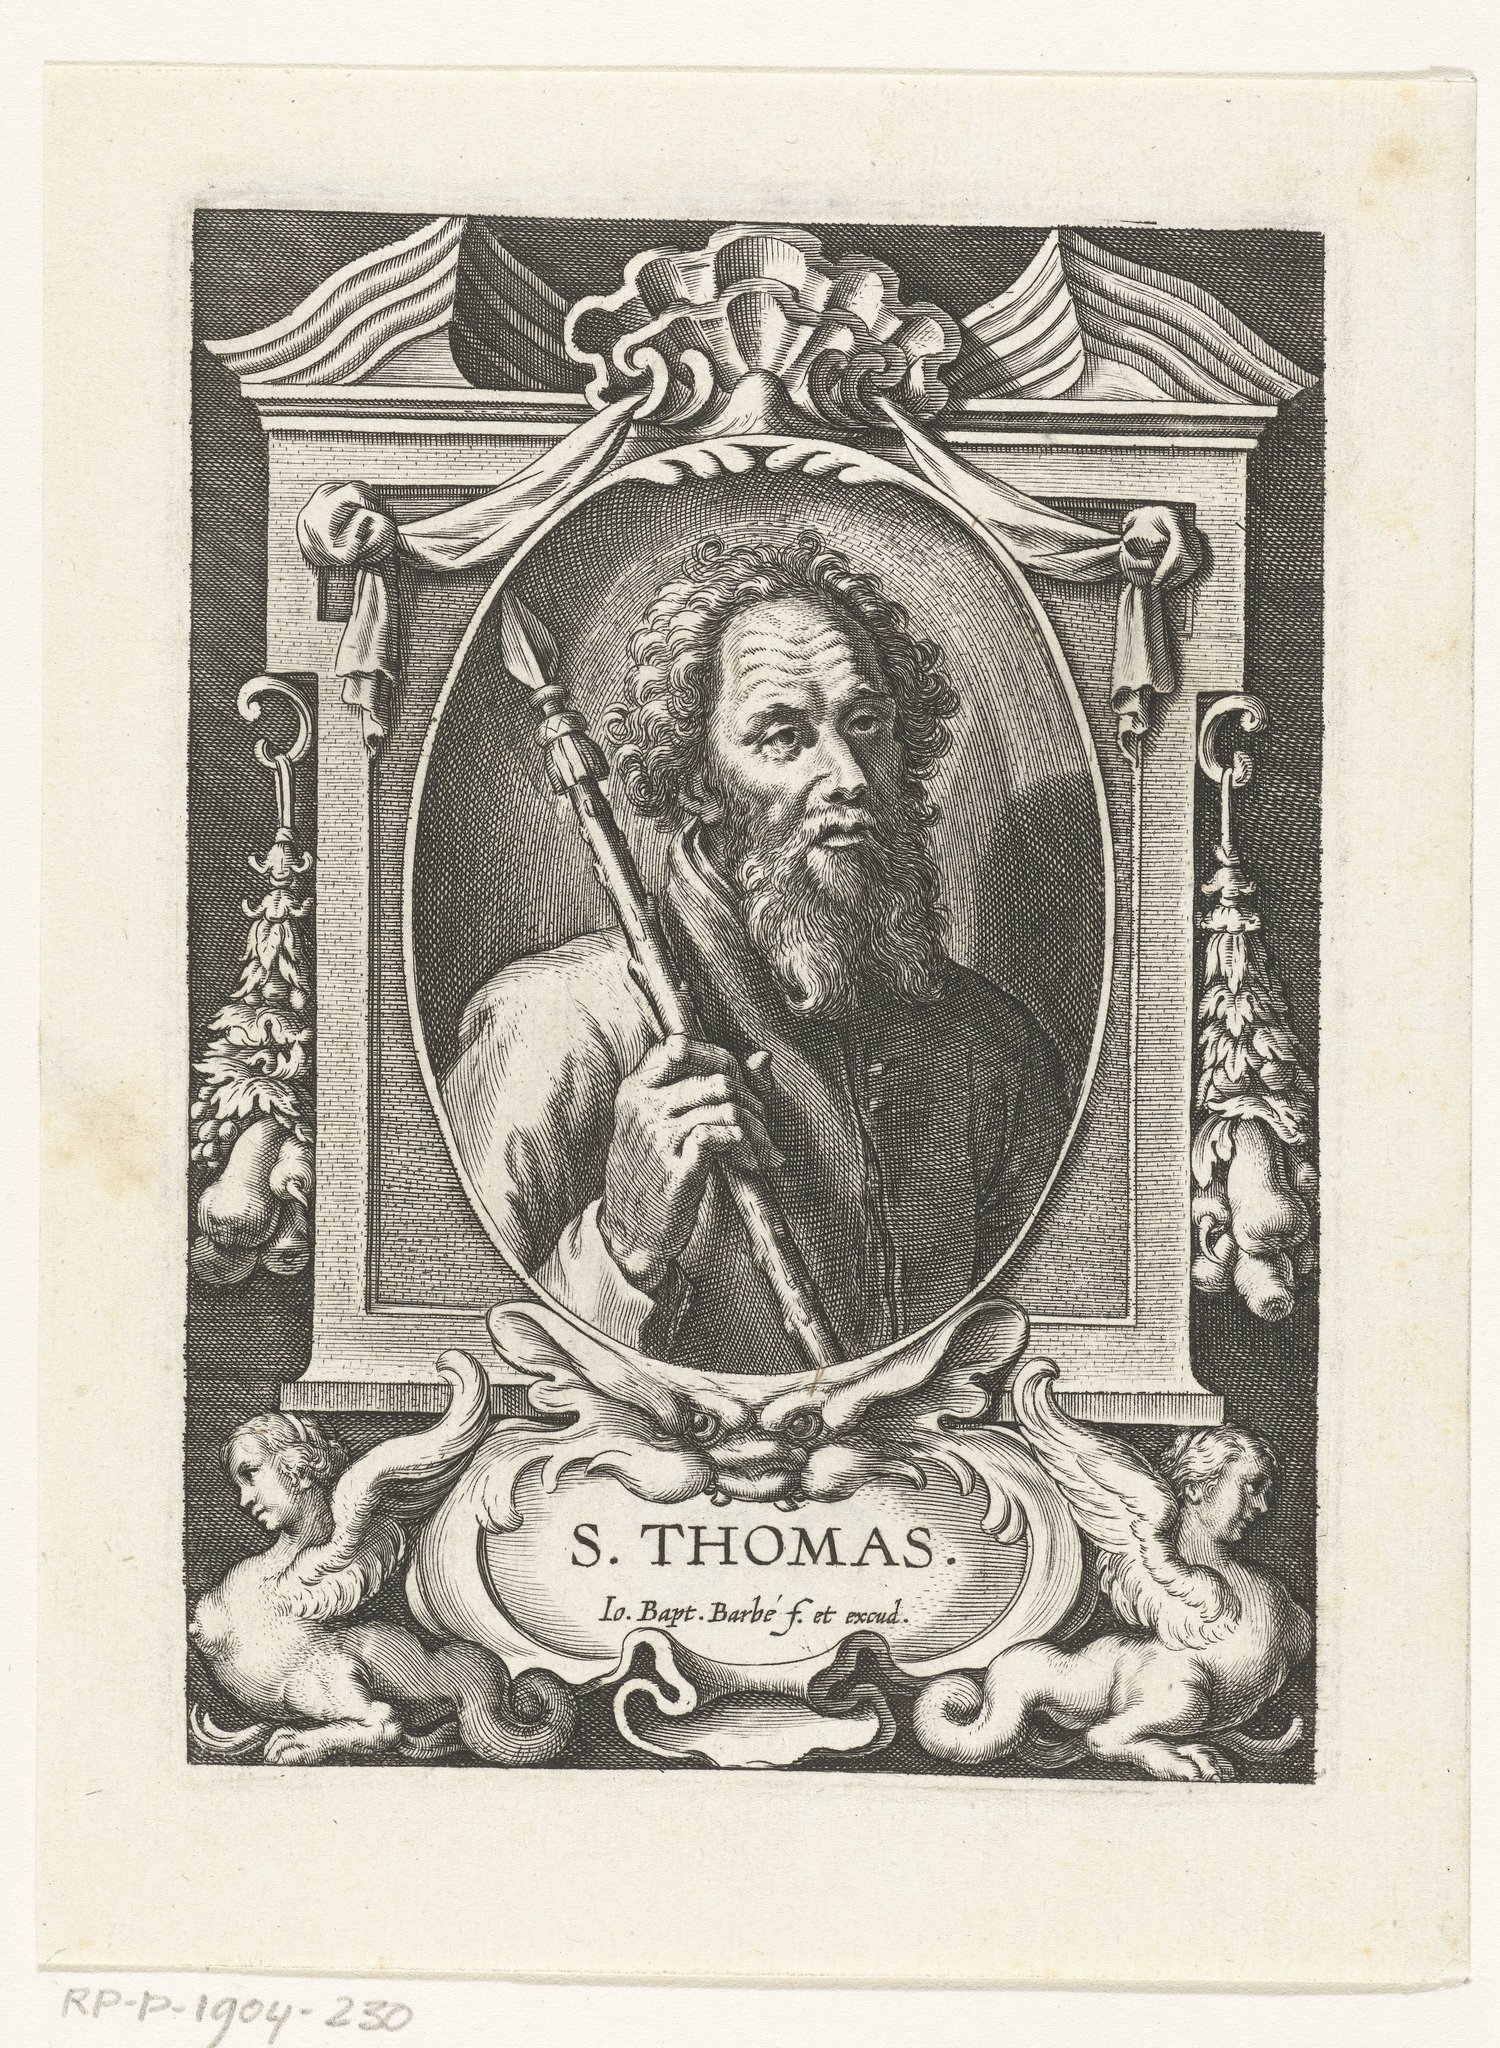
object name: print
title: SS. Apostolorum et Evangelistorum Icones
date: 1588-1648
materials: paper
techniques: engraving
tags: male saints (with name), ornament derived from architectural details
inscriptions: collector's mark: Lugt 2228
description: Het opschrift duidt deze apostel als de heilige Tomas maar dit is op basis van het uiterlijk en zijn attribuut niet correct. De heilige Judas Taddeüs wordt vaak met baard en een lans afgebeeld.